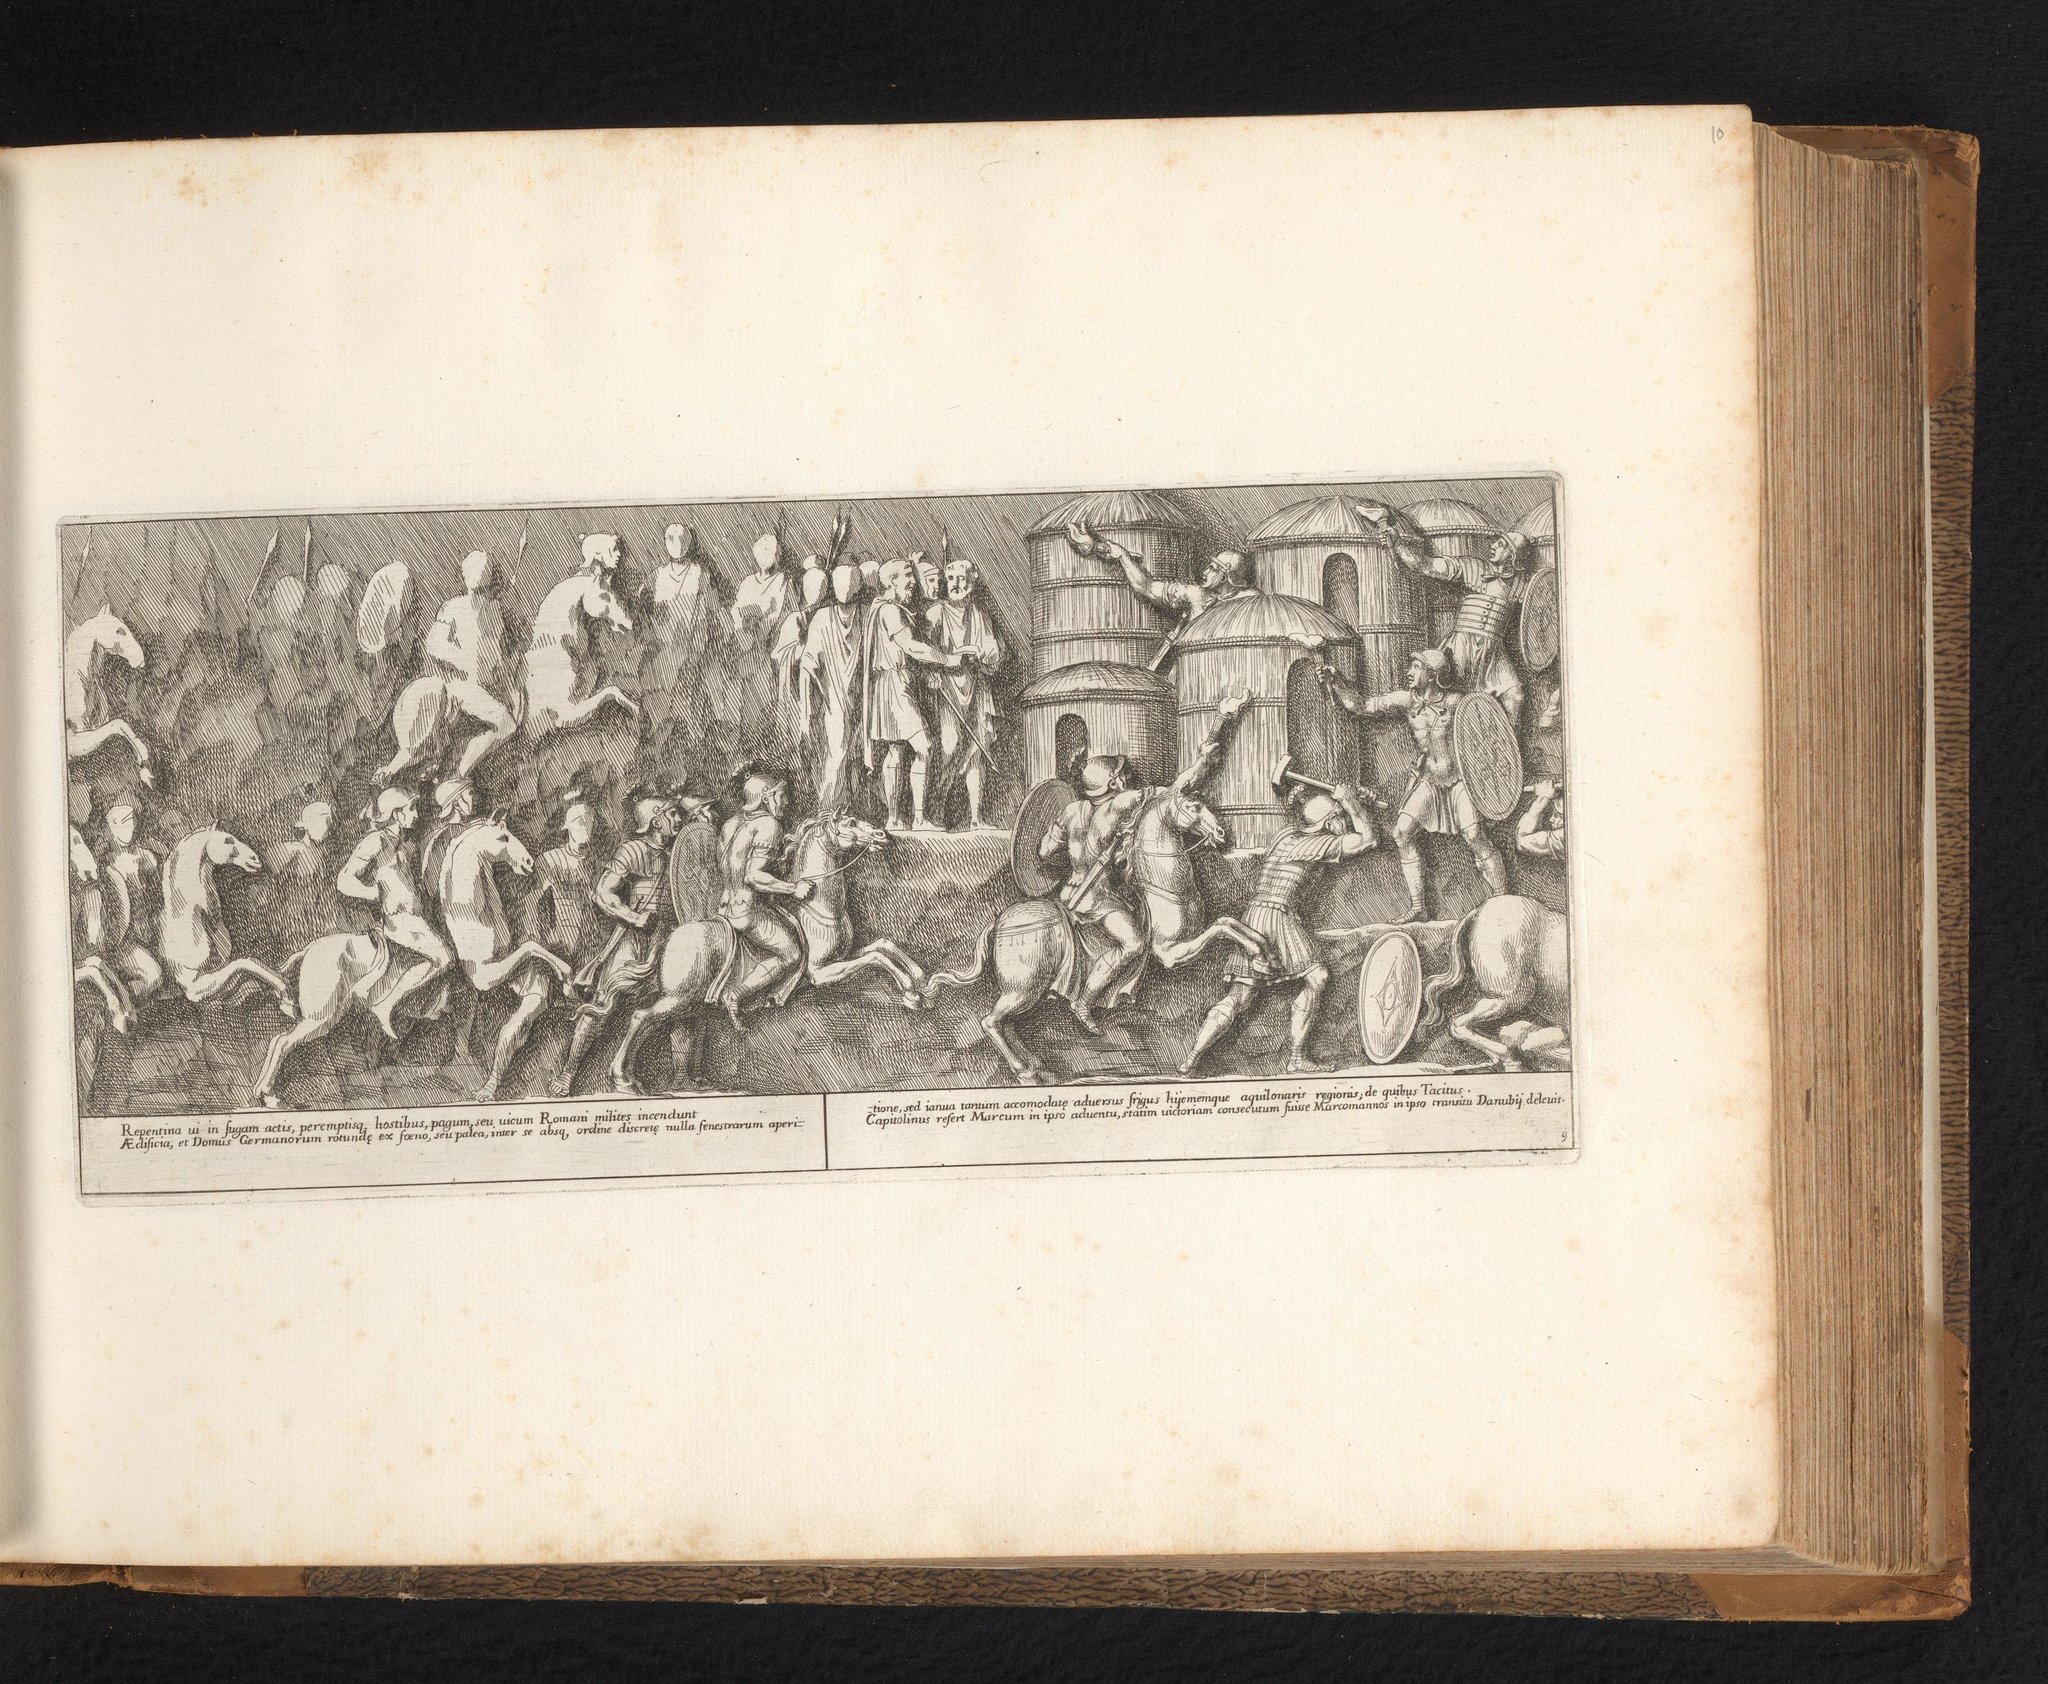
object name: print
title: Zuil van Marcus Aurelius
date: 1672-1675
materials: paper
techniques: etching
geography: rome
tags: triumphal column with helical friezes, piece of sculpture, reproduction of a piece of sculpture, the soldier; the soldier's life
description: Detail van het spiraalvormige gebeeldhouwde fries op de Zuil van Marcus Aurelius te Rome. Het fries toont de oorlog tussen het Romeinse leger van keizer Marcus Aurelius en de Germaanse stammen der Marcomannen en Quaden en de oorlog tegen de Sarmaten die vanuit het huidige Iran Hongarije waren binnengevallen. Tekst in de ondermarge. Prent maakt deel uit van een album.